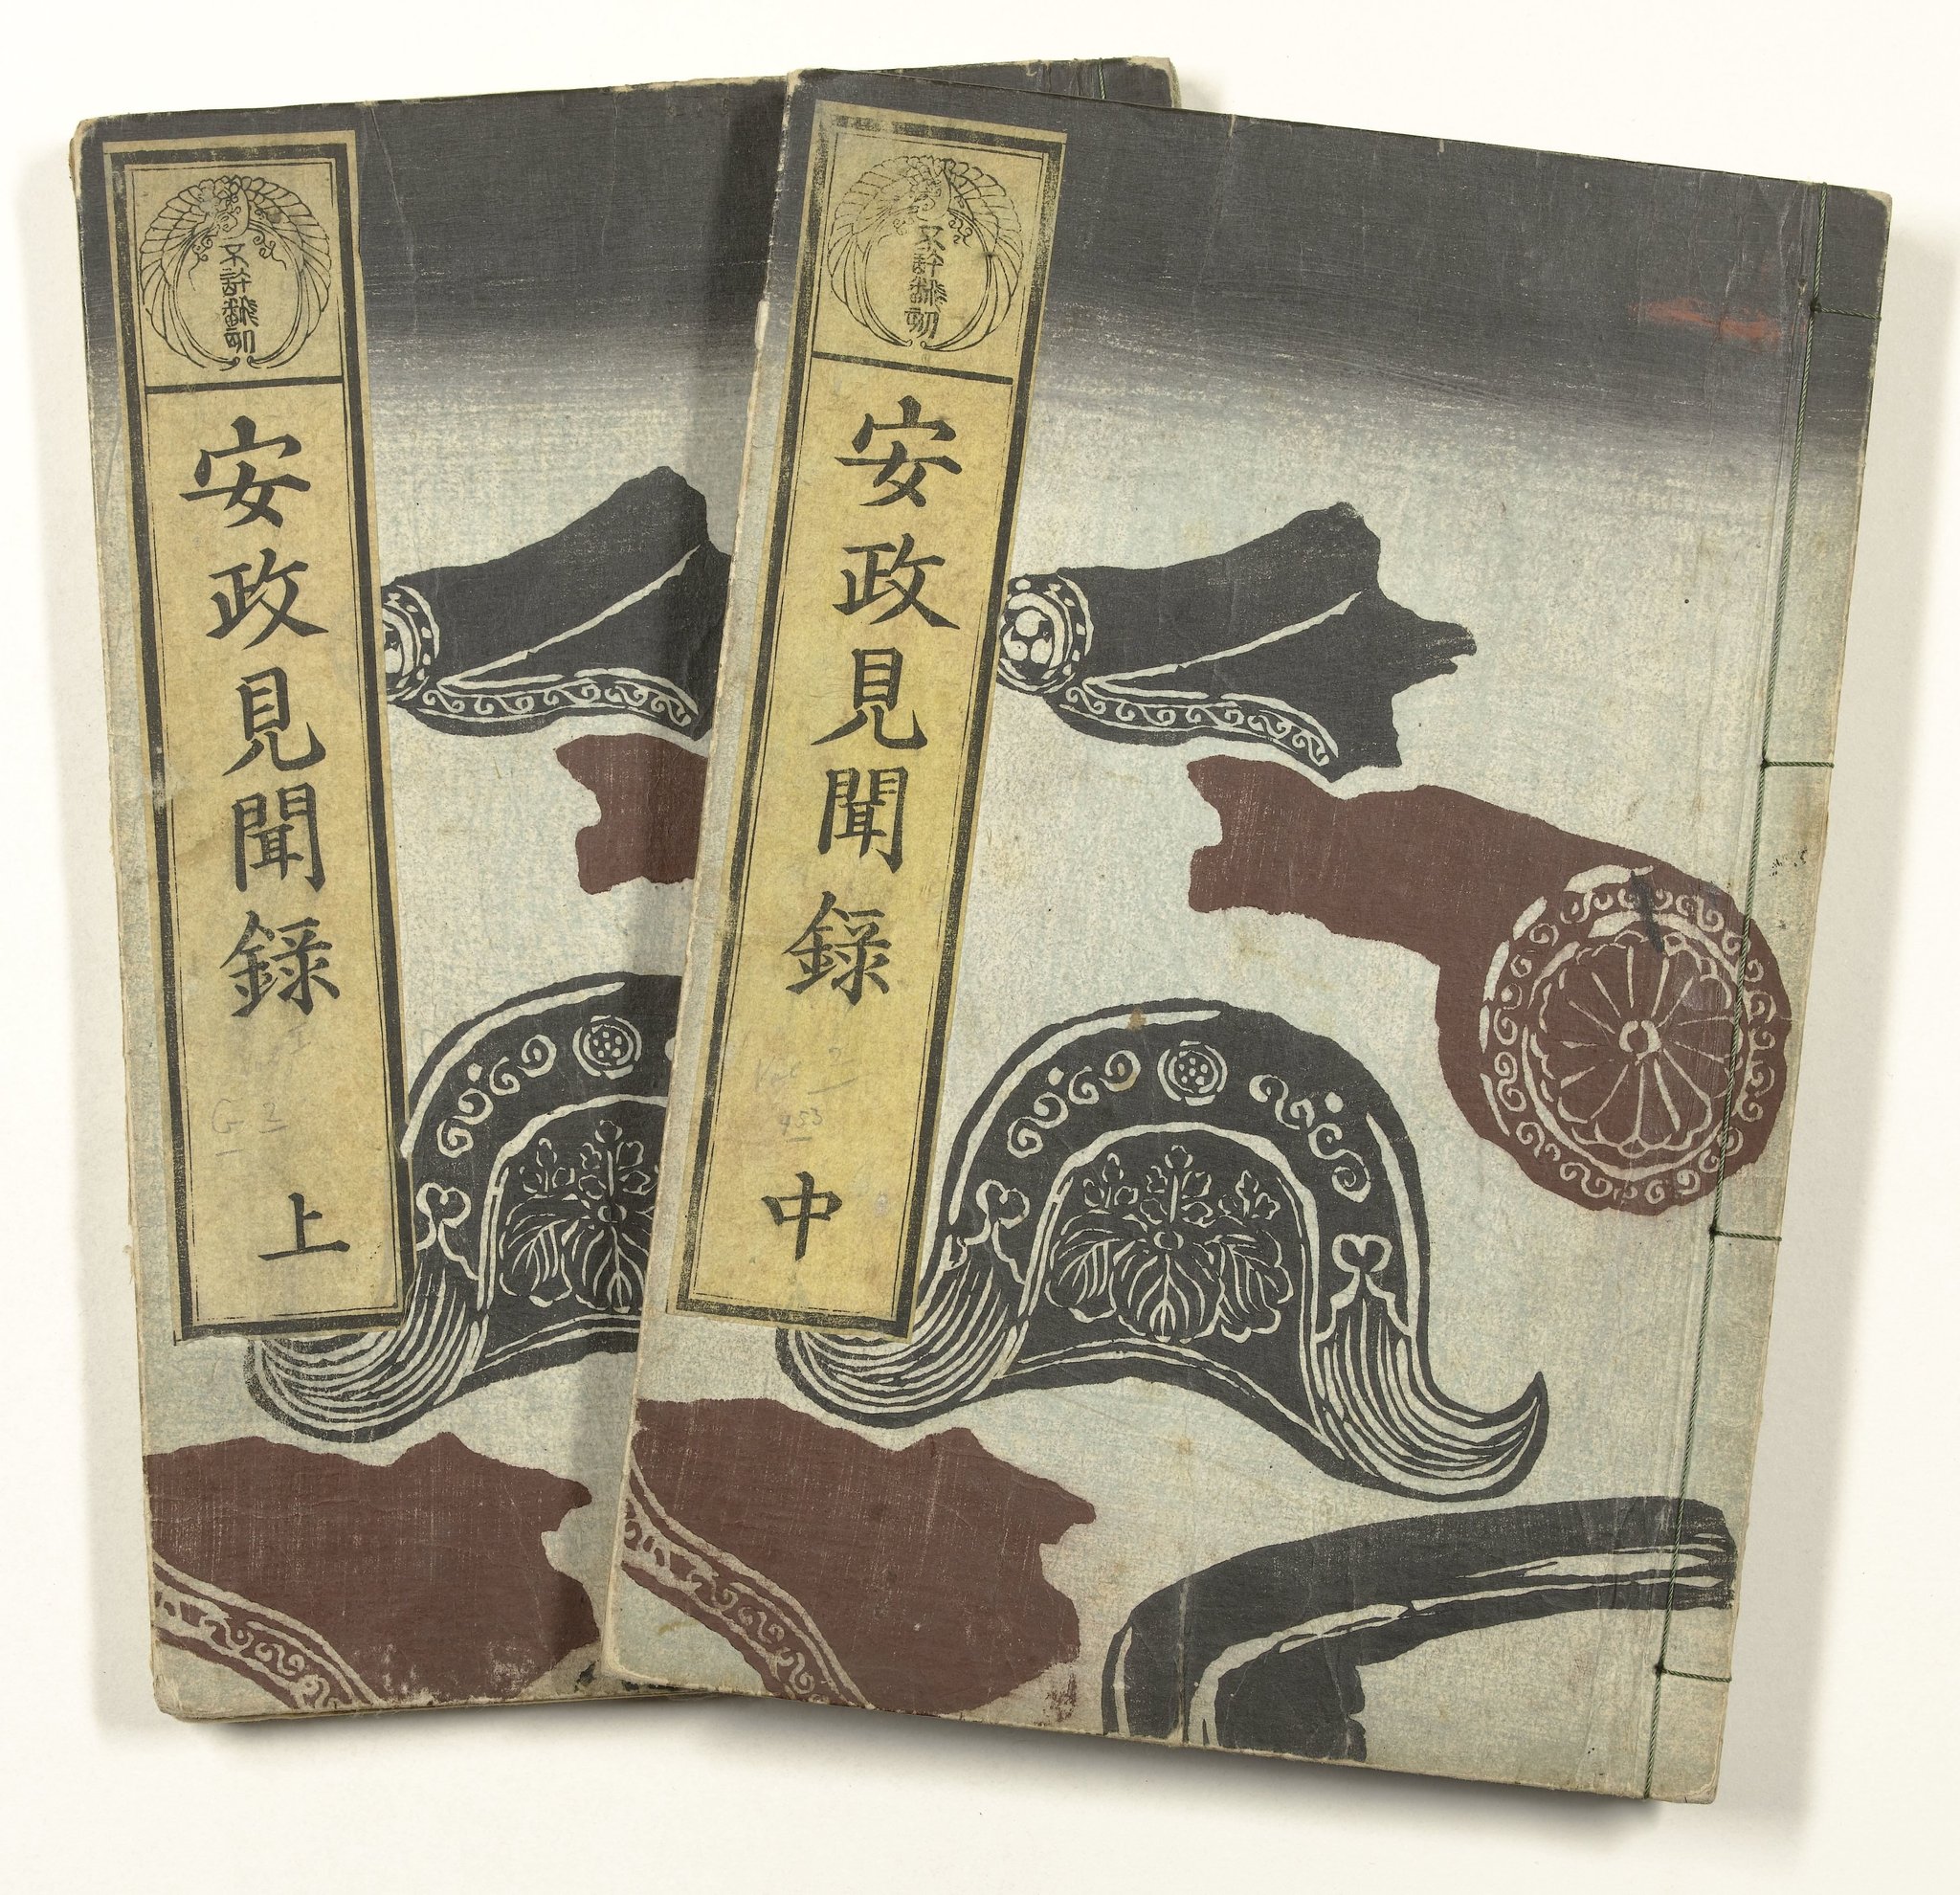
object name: book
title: Ansei kenmonroku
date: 1856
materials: paper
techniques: woodcut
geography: japan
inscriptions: collector's mark: Lugt 2228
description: Twee delen (van drie) waarin verslag wordt gedaan van de gebeurtenissen rondom de aardbeving en vloedgolf van 1855.